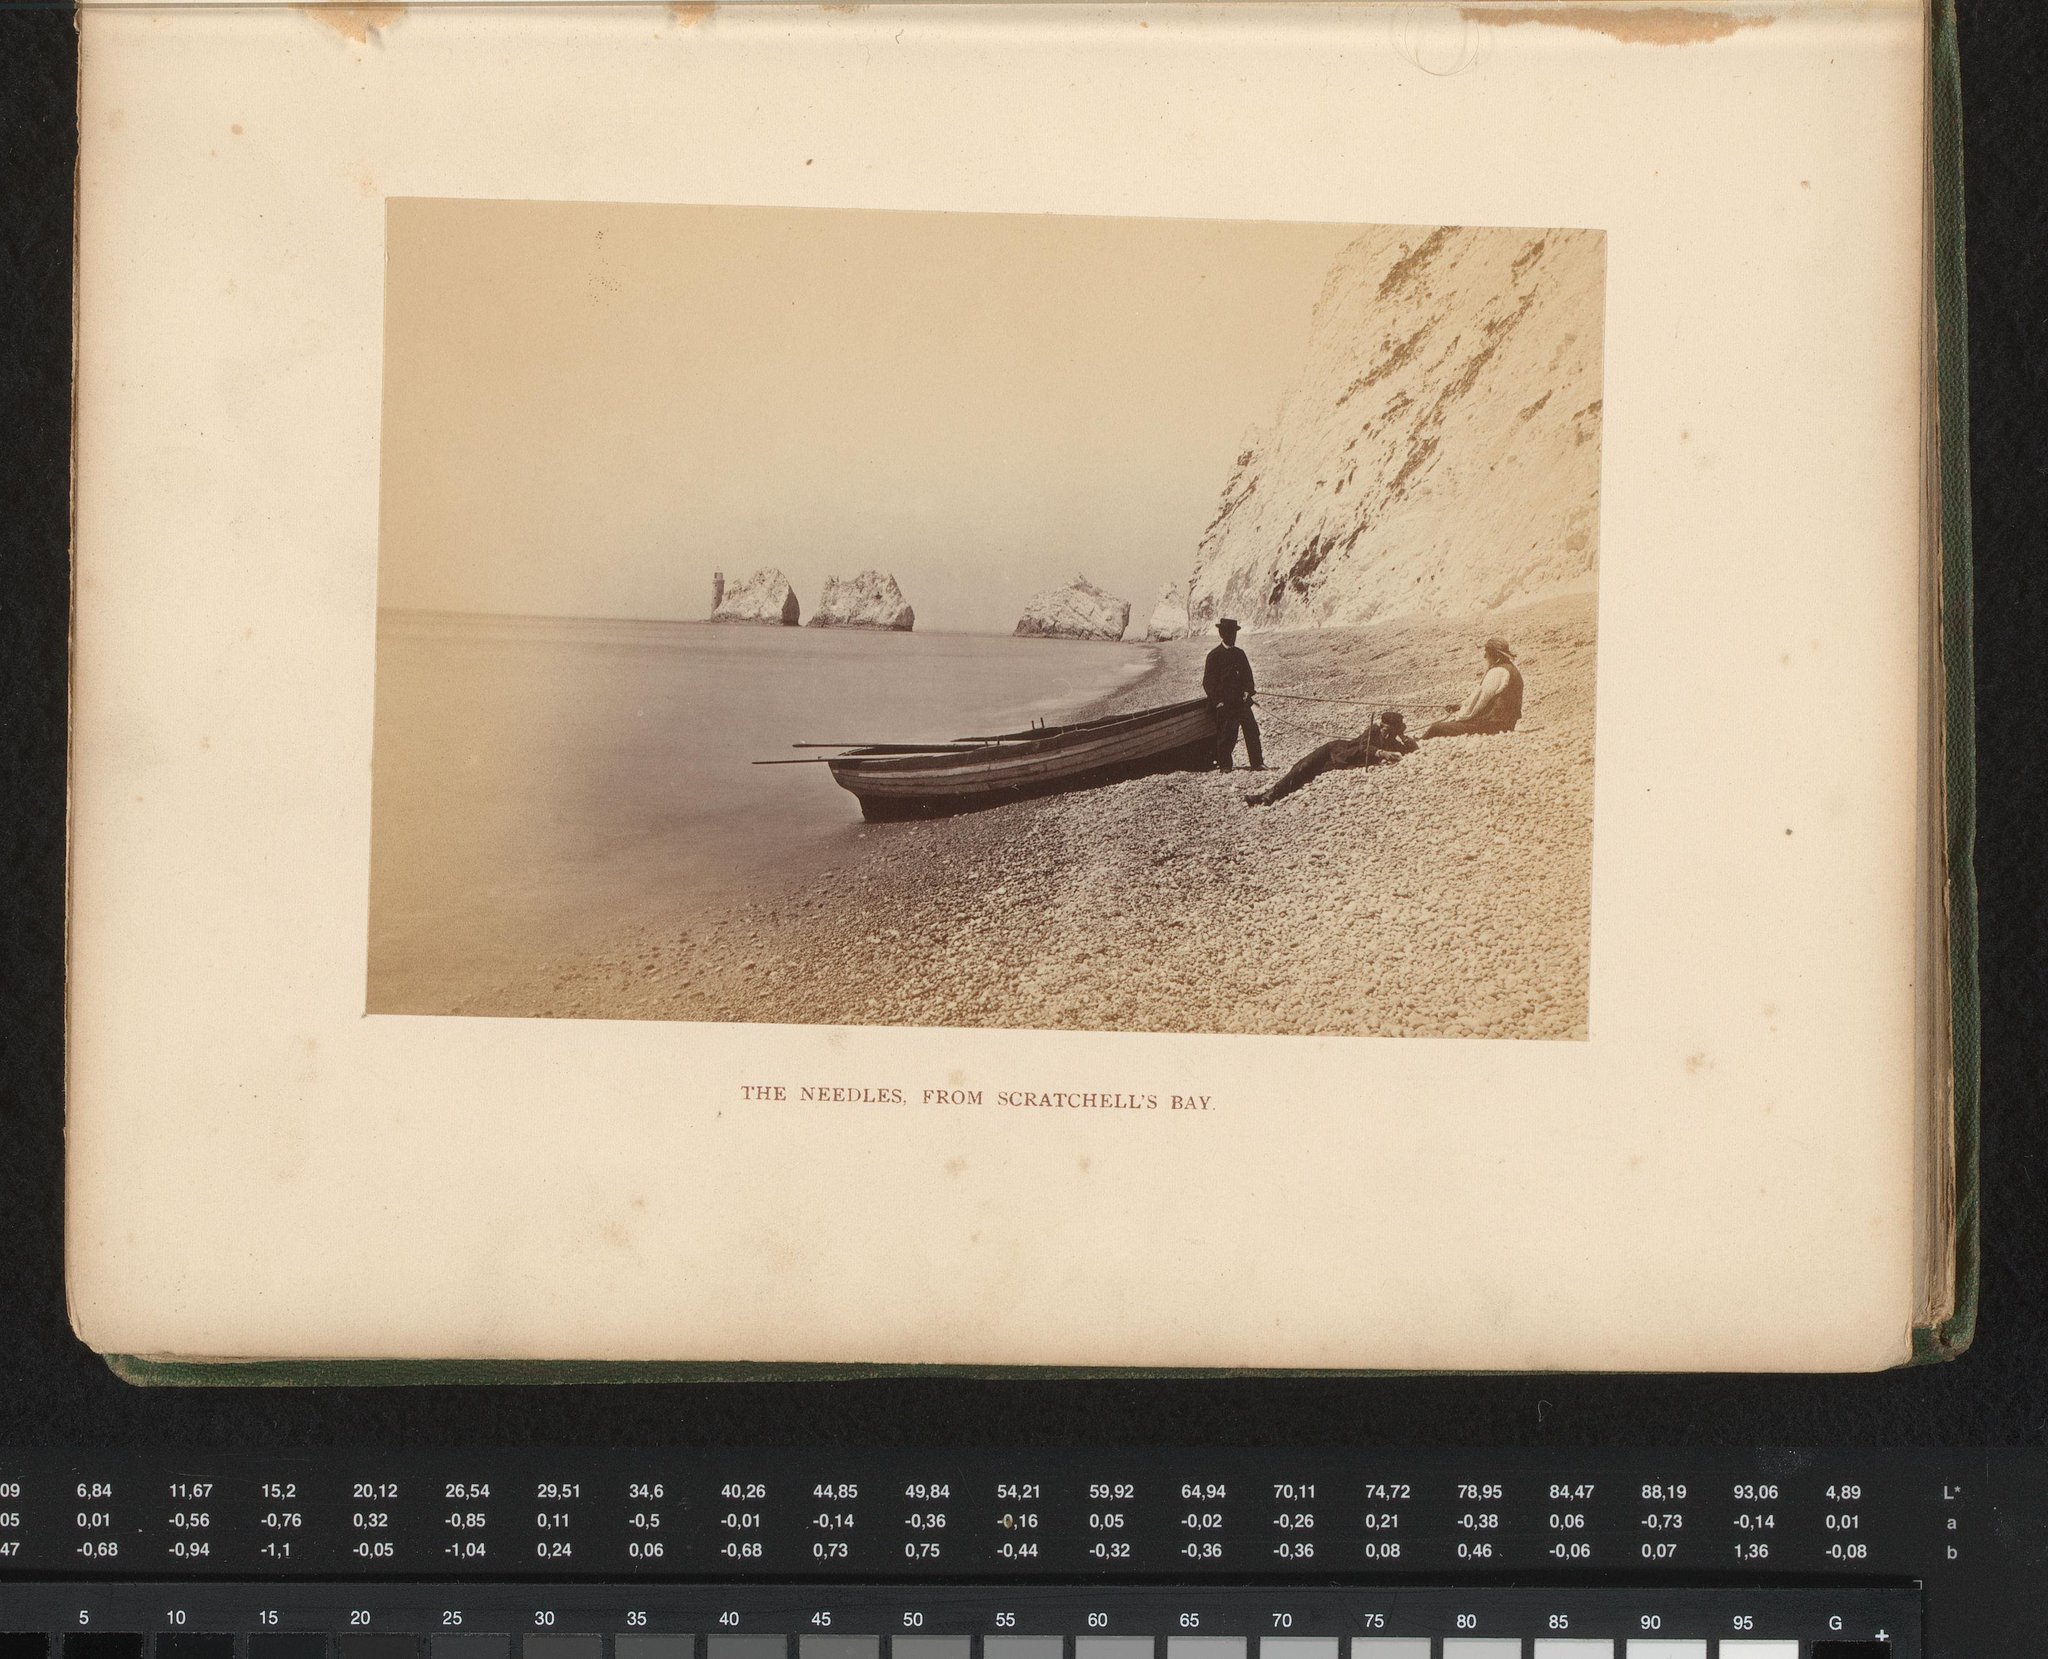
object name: page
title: The Needles from Scratchell's Bay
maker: frank mason good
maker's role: publisher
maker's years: 1839-1928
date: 1864-1869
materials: paper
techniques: albumen print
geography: scratchell's bay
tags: rocky coast, coastal cliff or crag